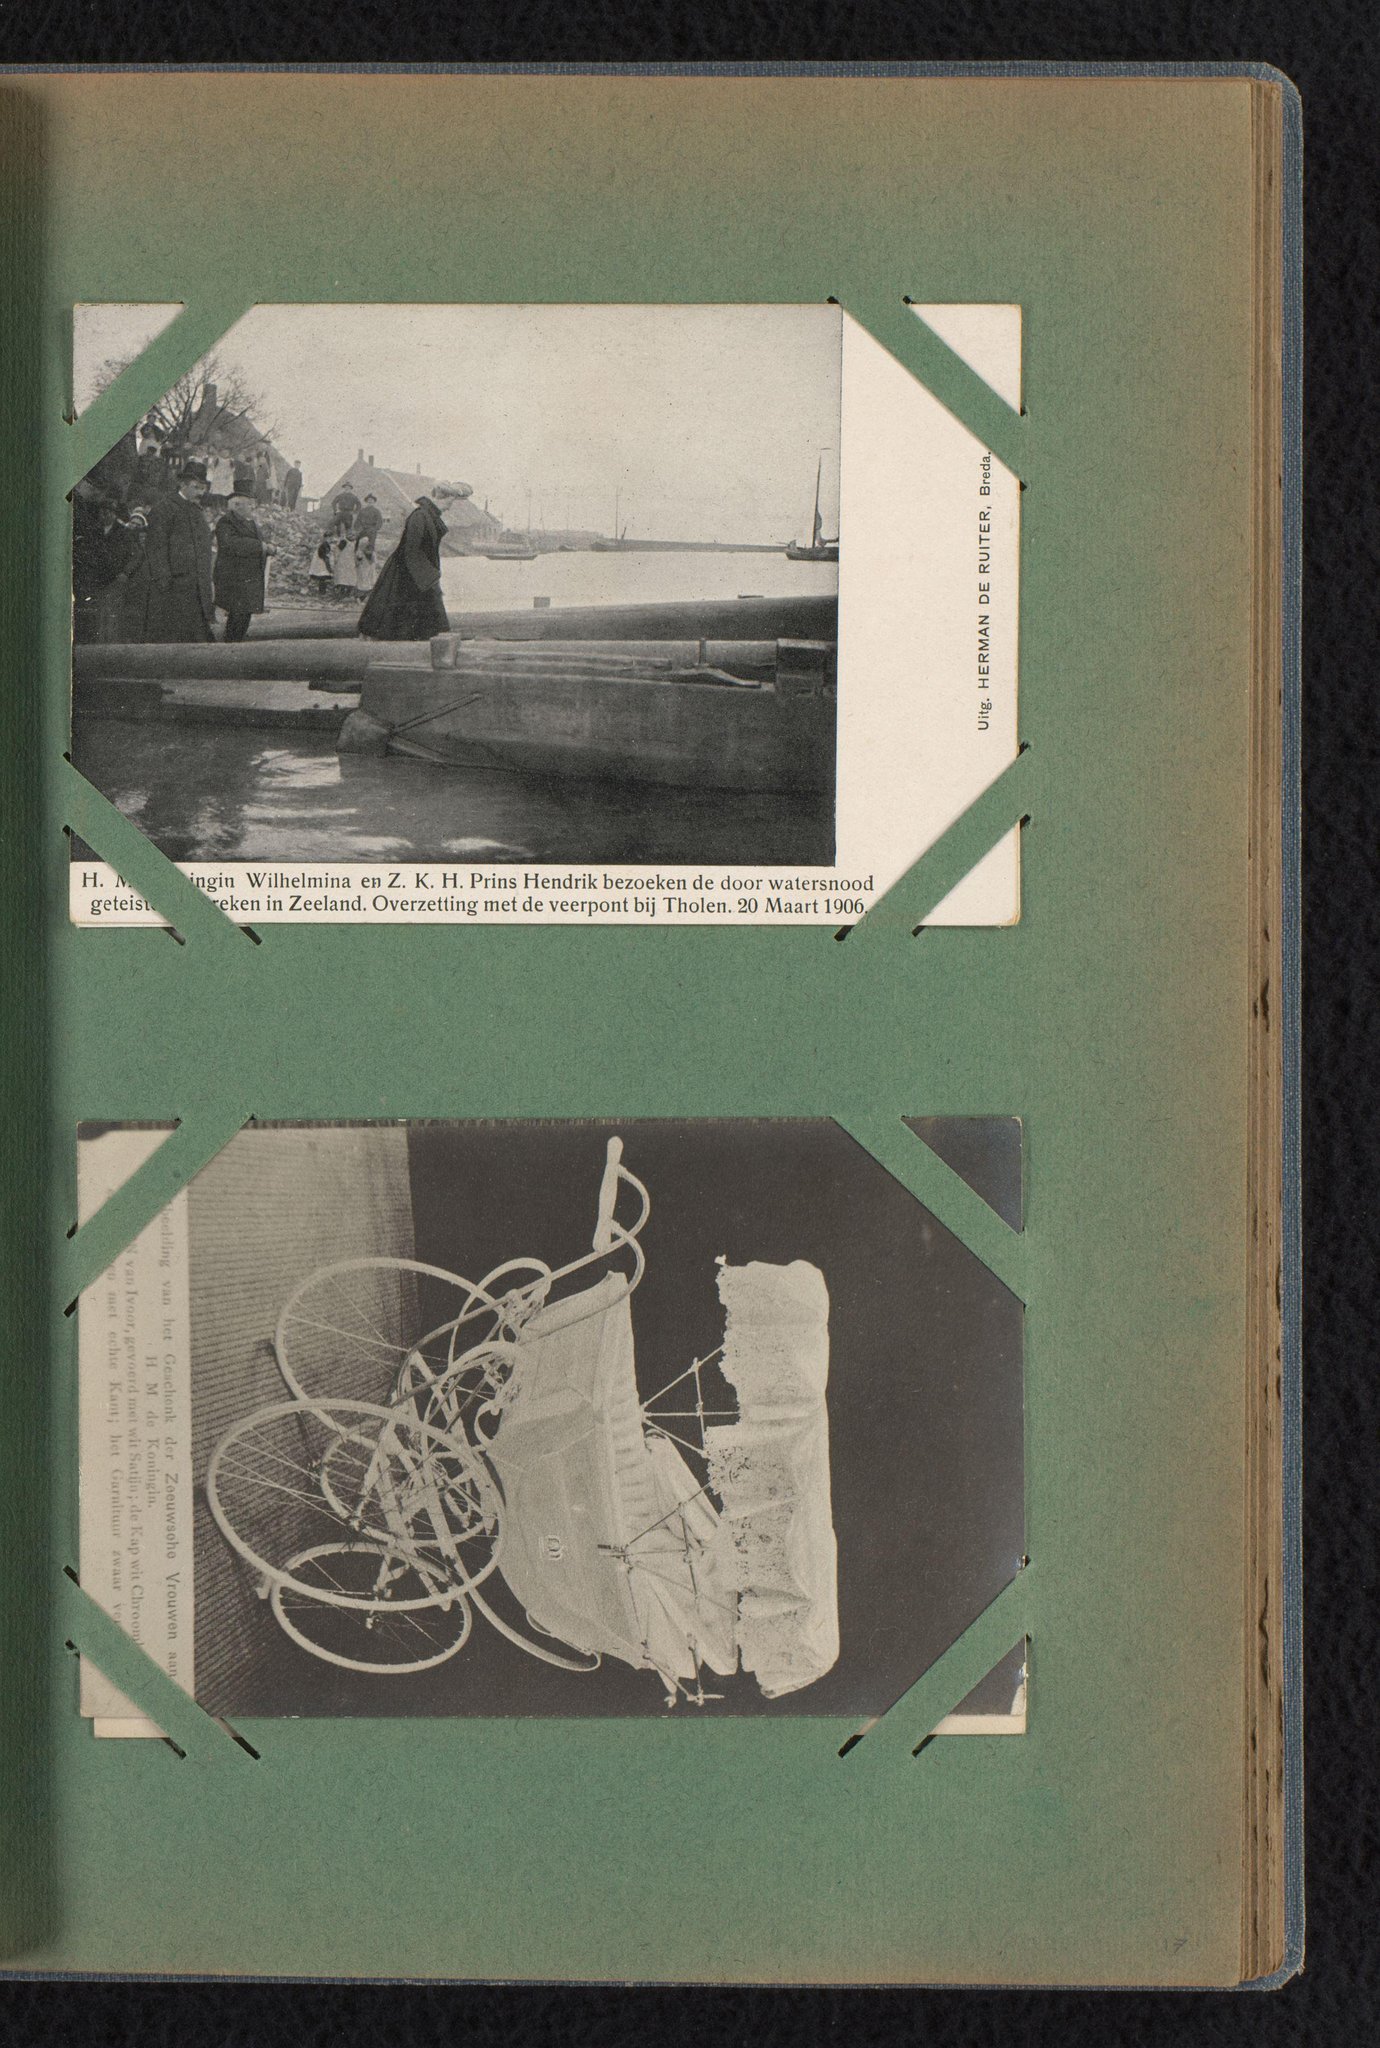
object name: ansichtkaart, prentbriefkaart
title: Twee prentbriefkaarten van een bezoek van koningin Wilhelmina na de Watersnoodramp van 1906 en van een kinderwagen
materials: paper, cardboard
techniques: gelatin silver print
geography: breda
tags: print maker, wilhelmina of the netherlands, baby-carriage, pram, perambulator, queen, flood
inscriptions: inscription: ‘Afbeelding van het Geschenk der Zeeuwsche Vrouwen aan/ H.M. de Koningin./ Wagen van Ivoor, gevoerd met wit Satijn; de Kap wit Chroomleder/ en omgeven met echte Kant; het Garnituur zwaar verzilverd.’, inscription: ‘H.M. Koningin Wilhelmina en Z.K.H. Prins Hendrik bezoeken de door watersnood/ geteisterde streken in Zeeland. Overzetting met de veerpont bij Tholen. 20 Maart 1906.’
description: Deze prent en foto maken deel uit van een album.